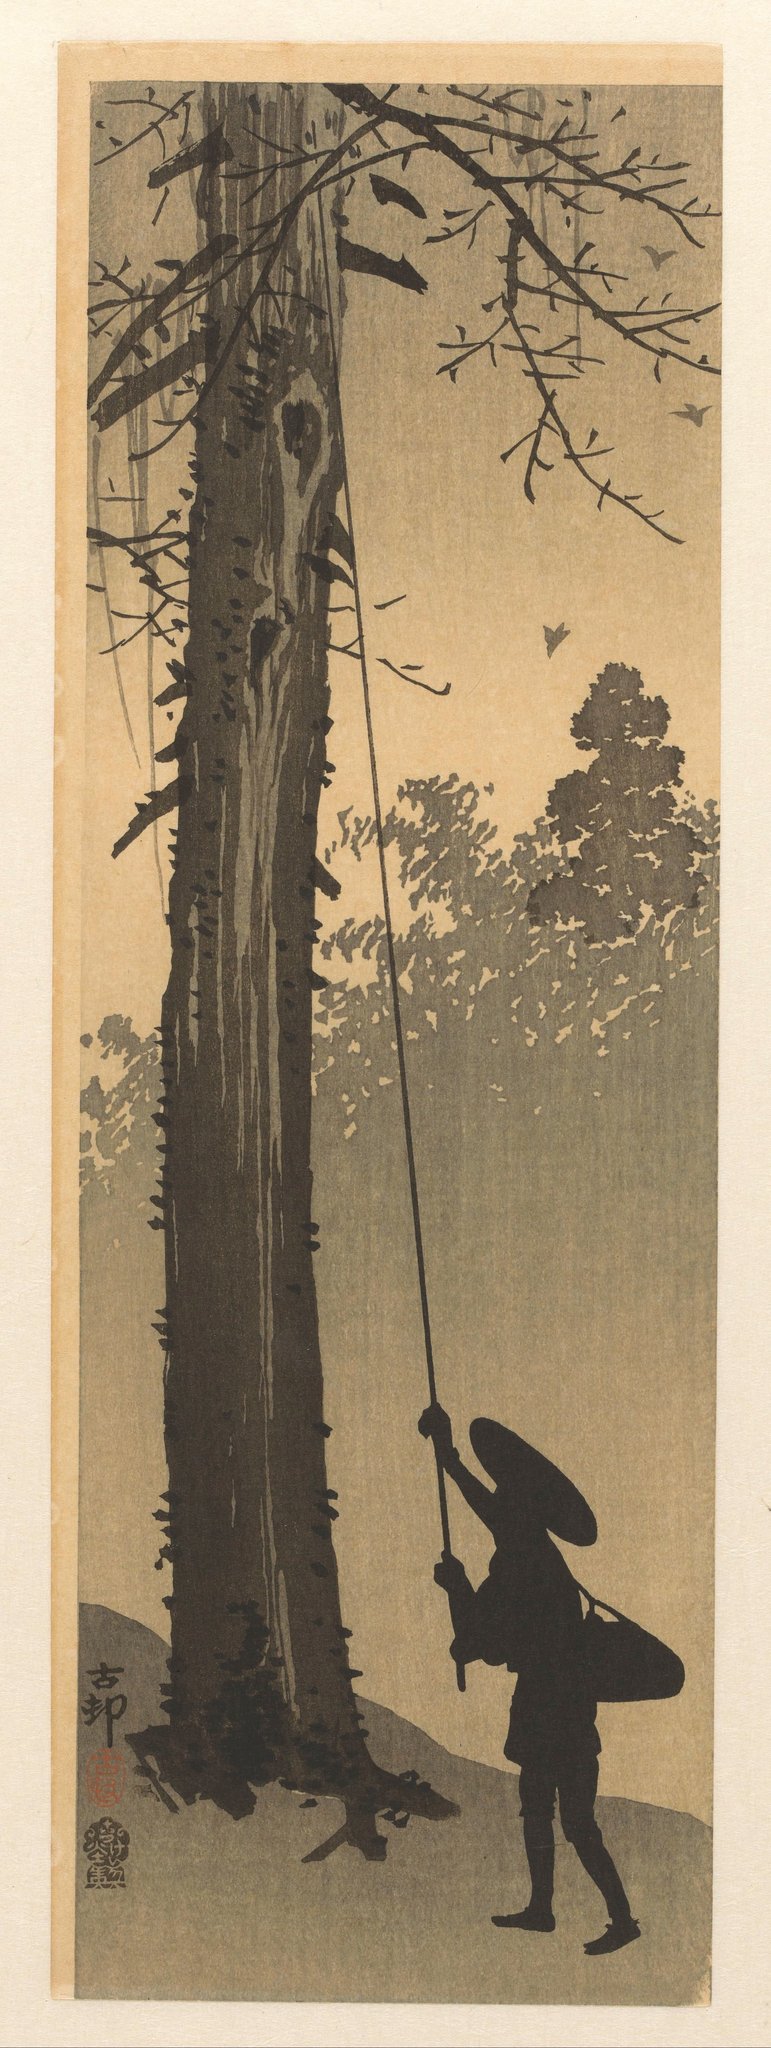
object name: print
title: Vogelnest rover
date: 1900-1910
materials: paper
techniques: woodcut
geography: tokyo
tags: standing figure, trees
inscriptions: collector's mark: Lugt 2228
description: Silhouet van een man met hoed, tas en lange stok, staand bij hoge boom.